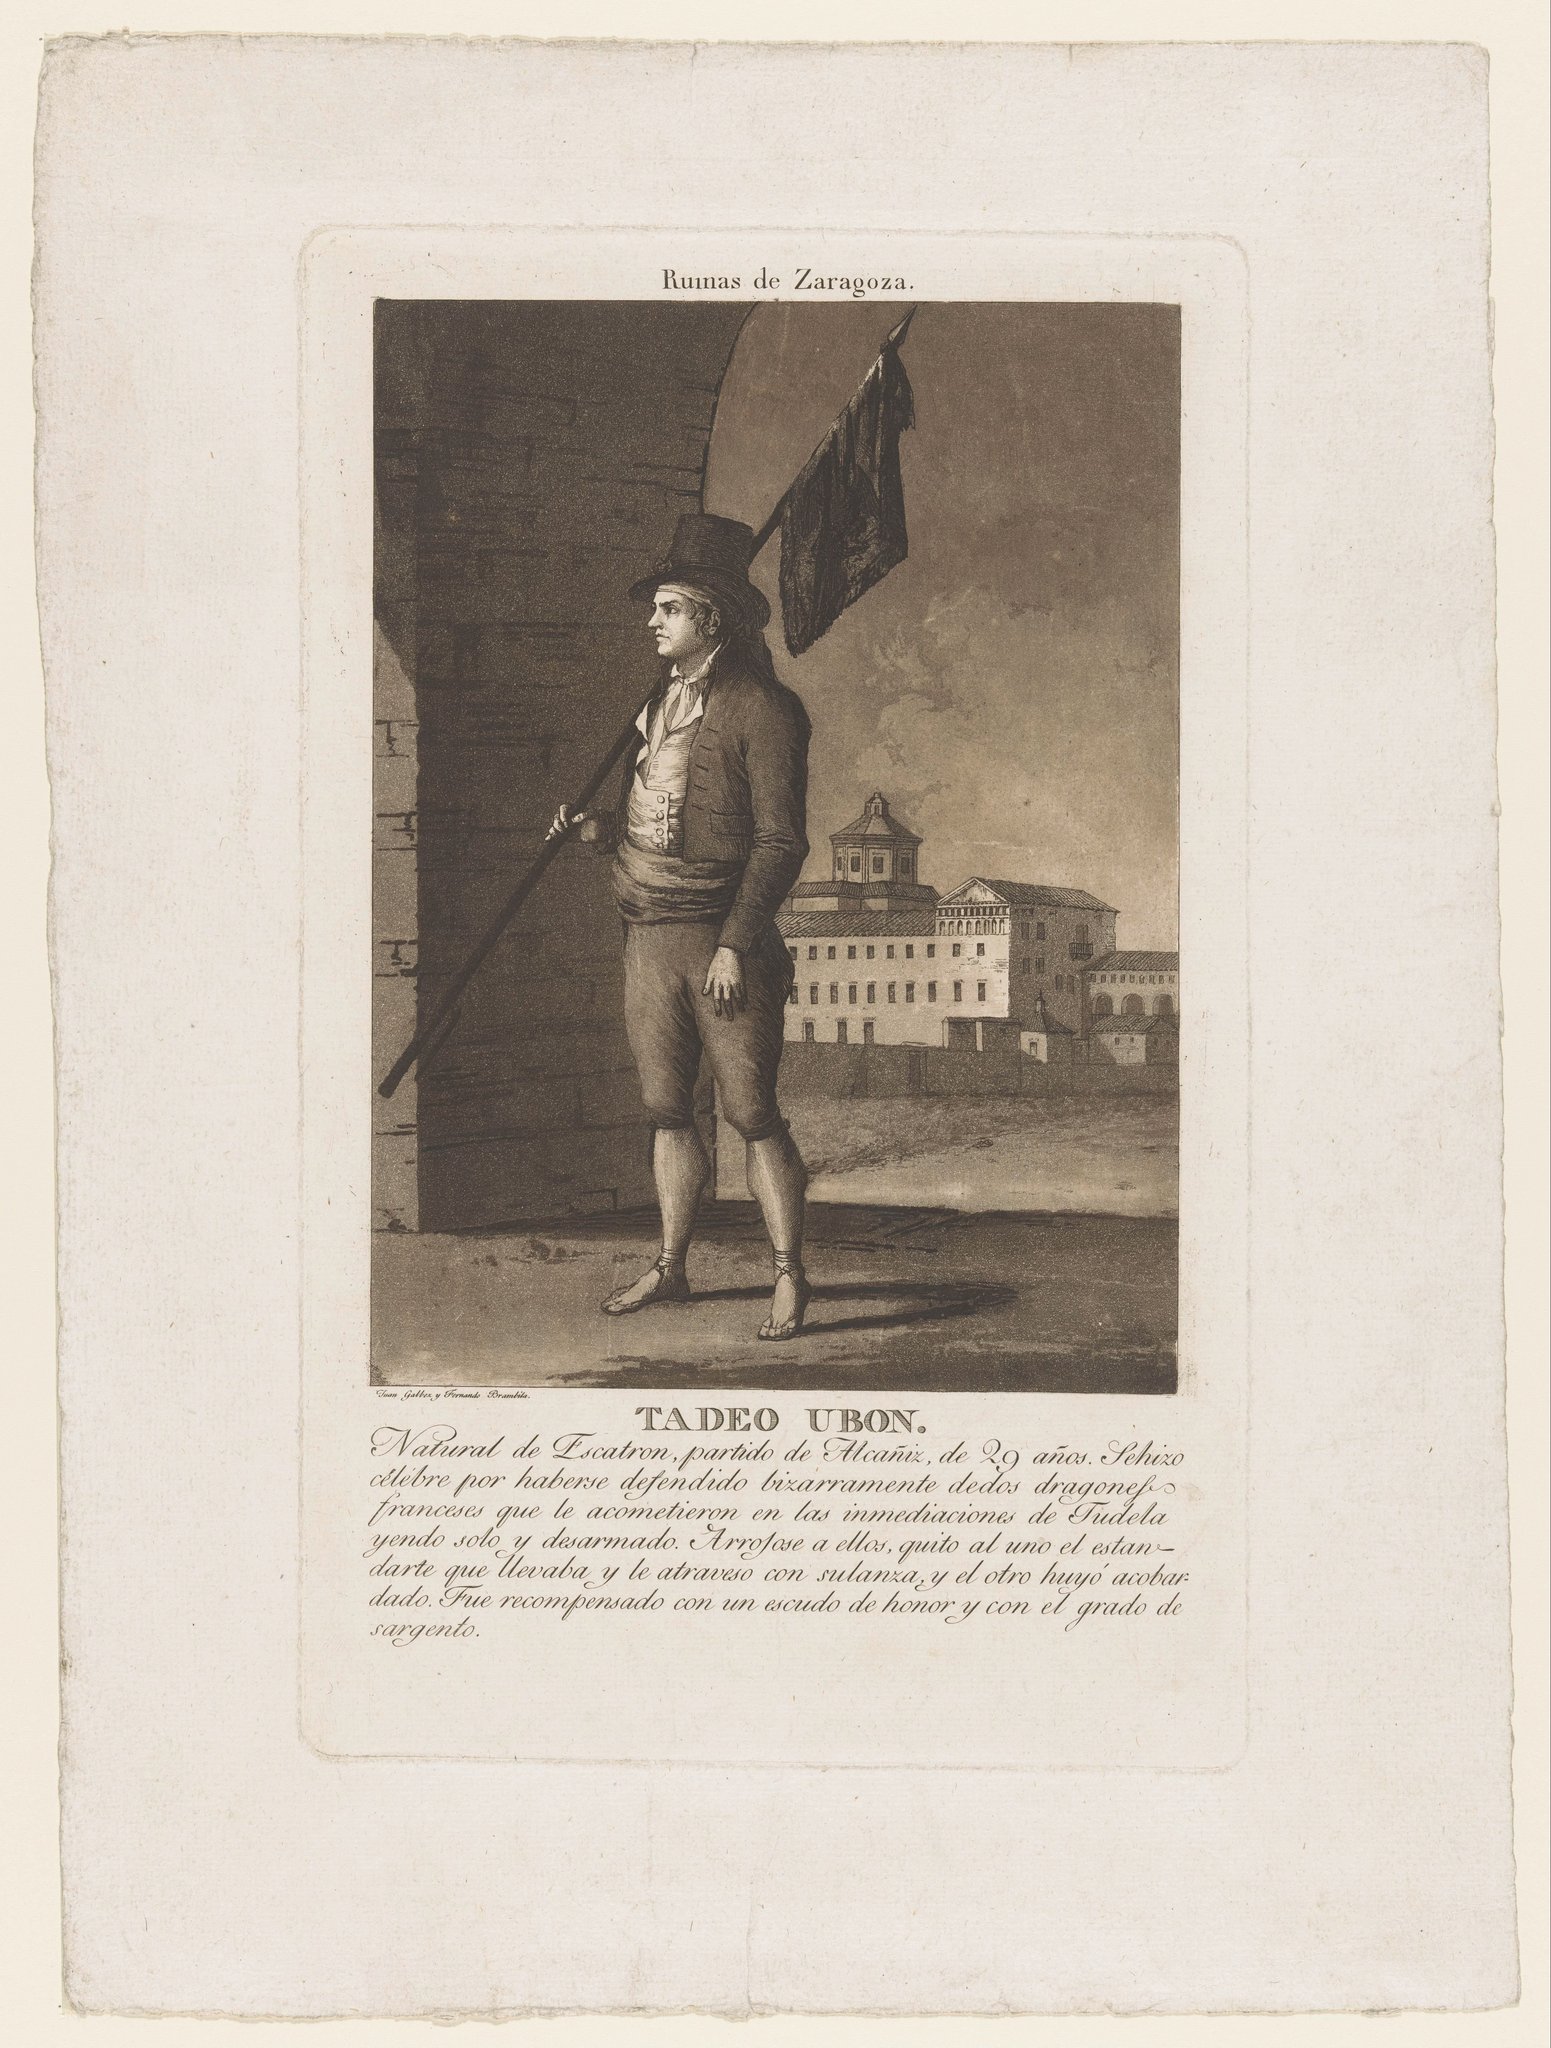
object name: print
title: Ruïnes van Zaragoza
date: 1808-1814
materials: paper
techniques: aquatint, etching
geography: madrid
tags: standing figure, banner, standard (as symbol of the state, etc.), head-gear: top hat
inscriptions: collector's mark: Lugt 2228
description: Deze prent maakt deel uit van een serie bestaande uit 36 prenten over de Franse aanvallen op de Spaanse stad Zaragoza in 1808. De serie werd uitgegeven tussen 1812 en 1814.